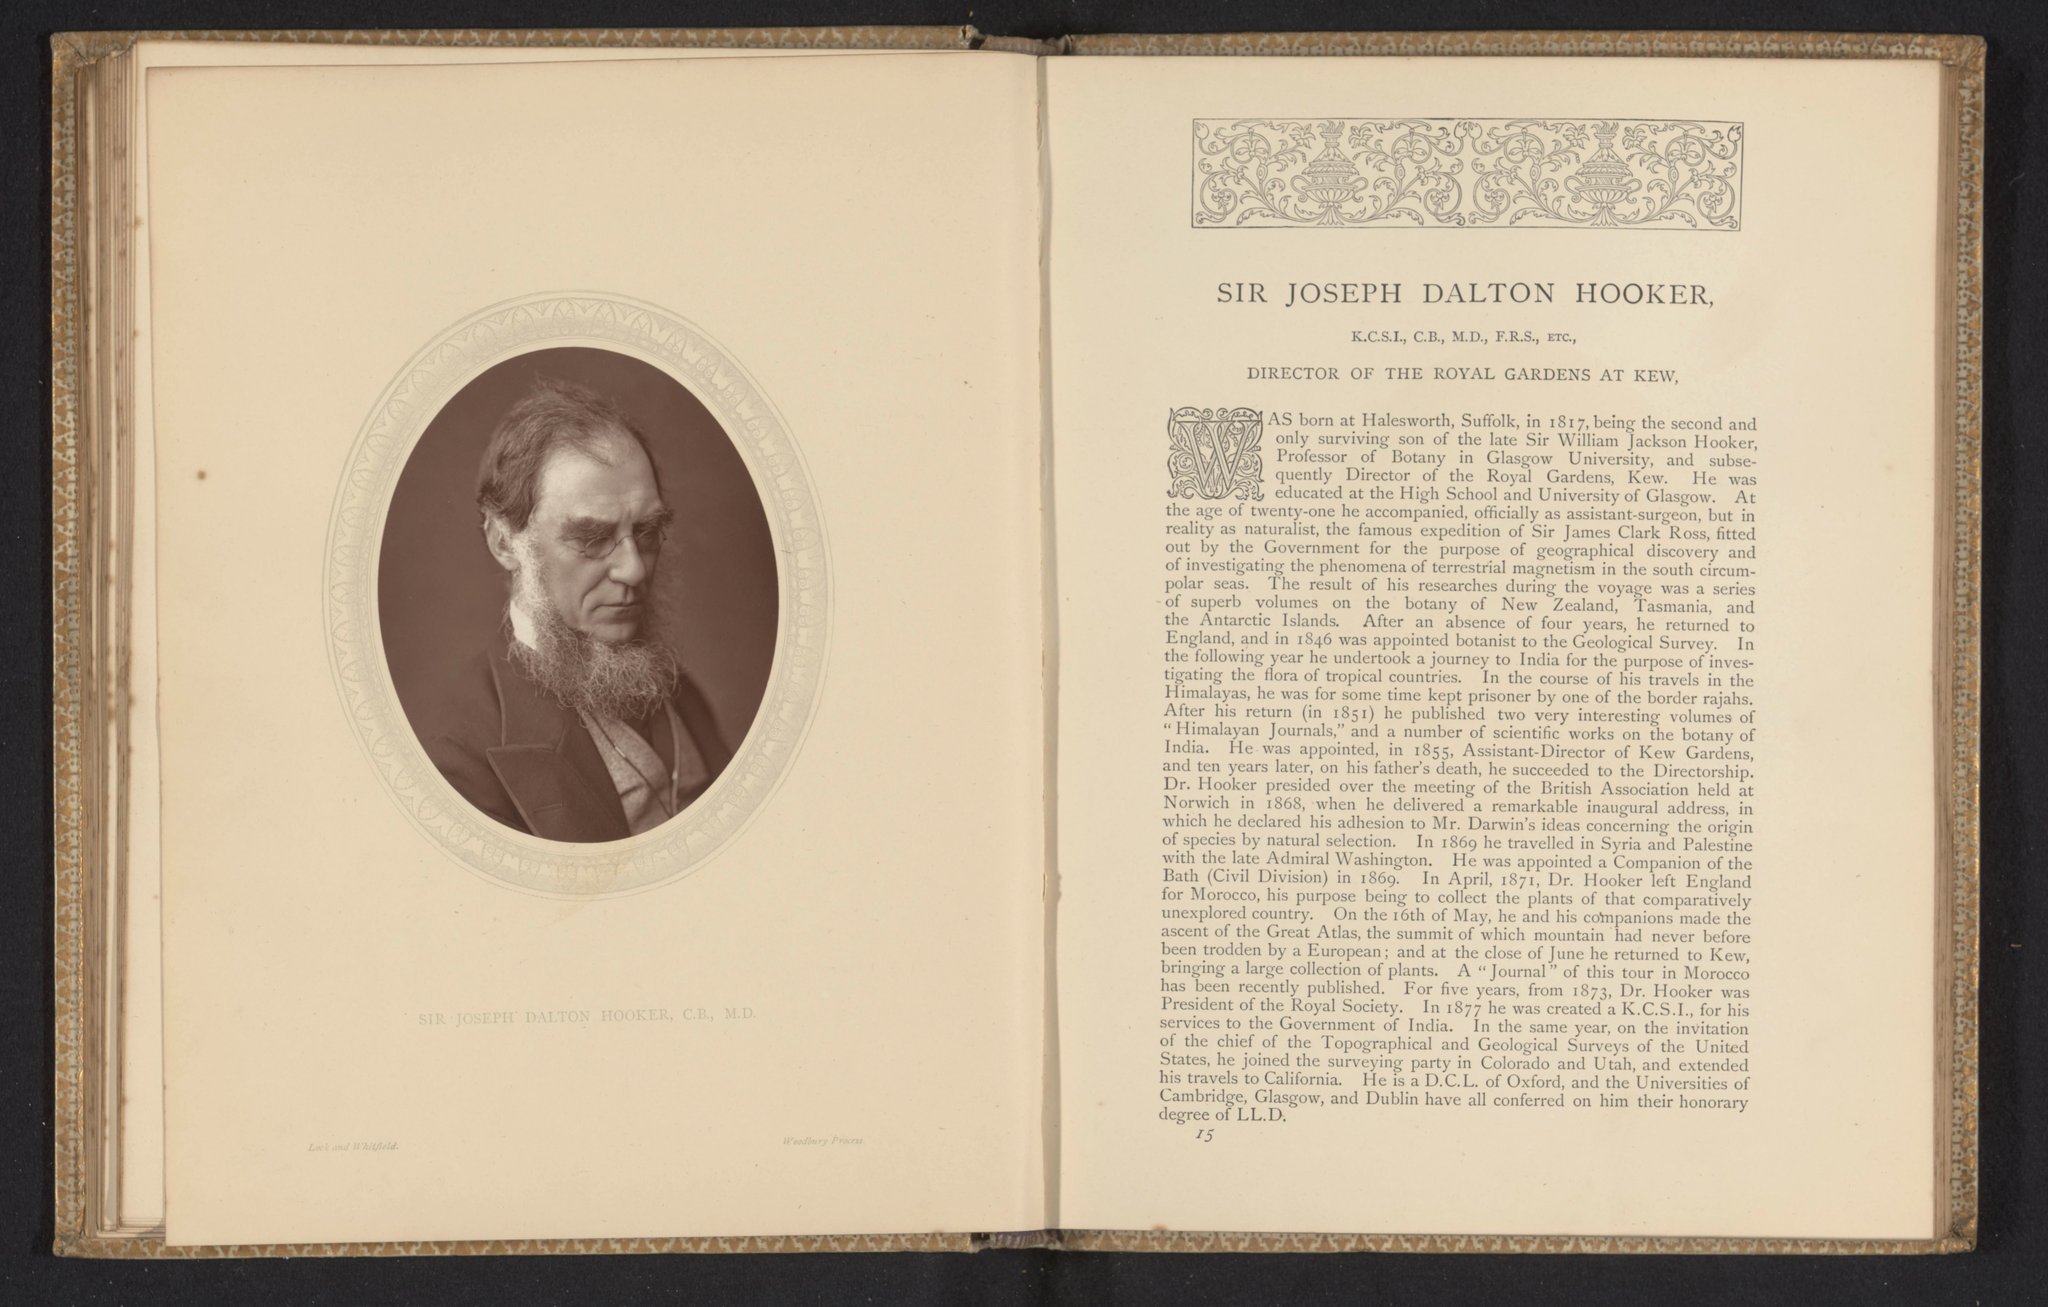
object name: page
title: Sir Joseph Dalton Hooker, C.B., M.D.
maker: Anonymous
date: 1876-1881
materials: paper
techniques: woodburytype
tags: historical persons (portraits and scenes from the life) (+ (full) bust portrait), botanizing